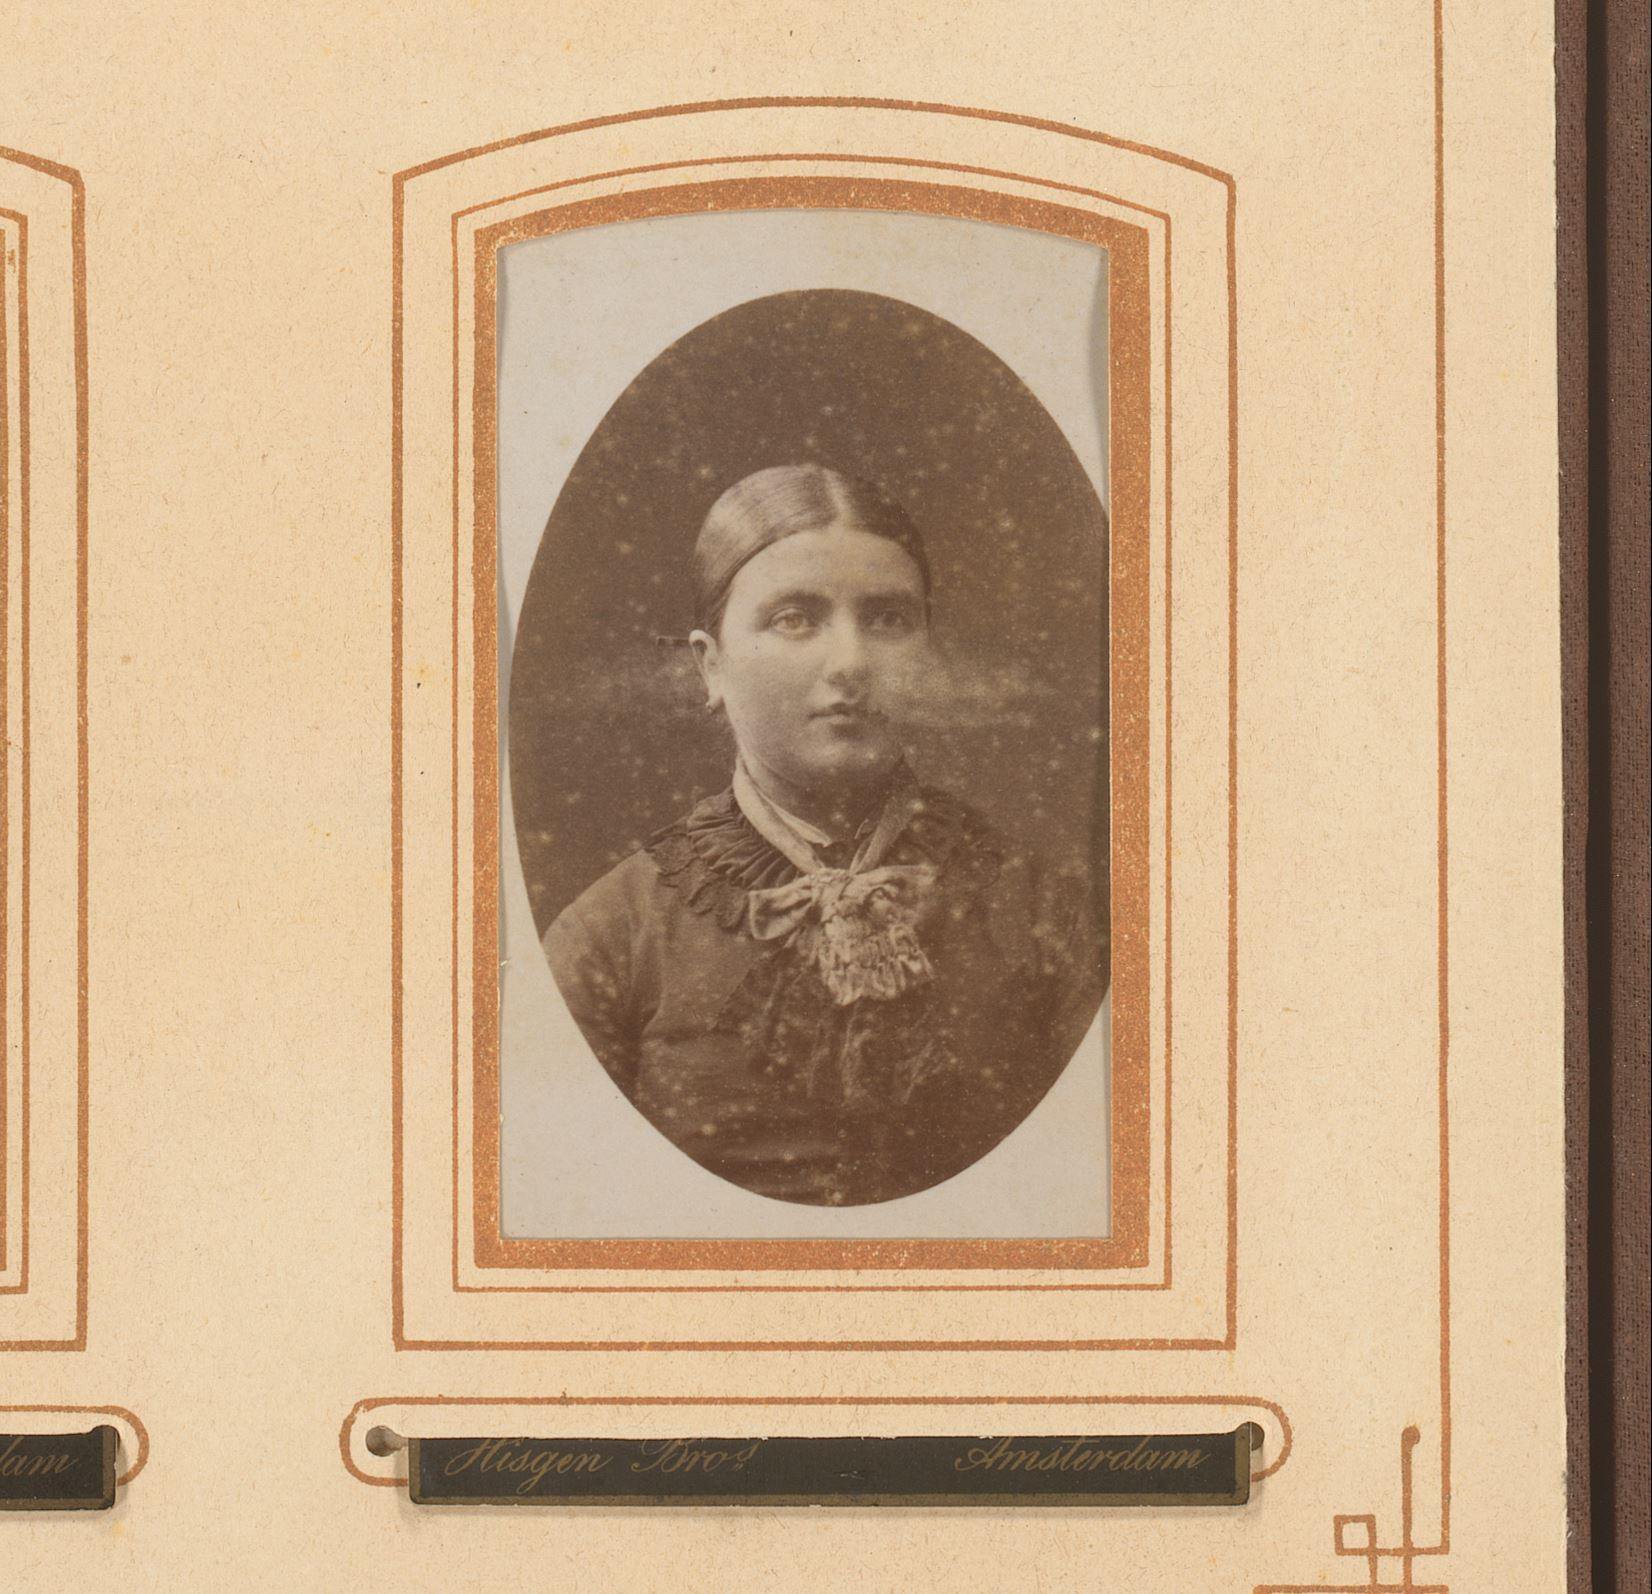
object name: album leaf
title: Portret van een vrouw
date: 1877-1884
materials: cardboard, photographic support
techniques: albumen print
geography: amsterdam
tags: historical persons - bb - woman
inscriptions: inscription: ‘American Photography/ Hisgen Bros./ 128. P.C. Hooftstraat/ Amsterdam’